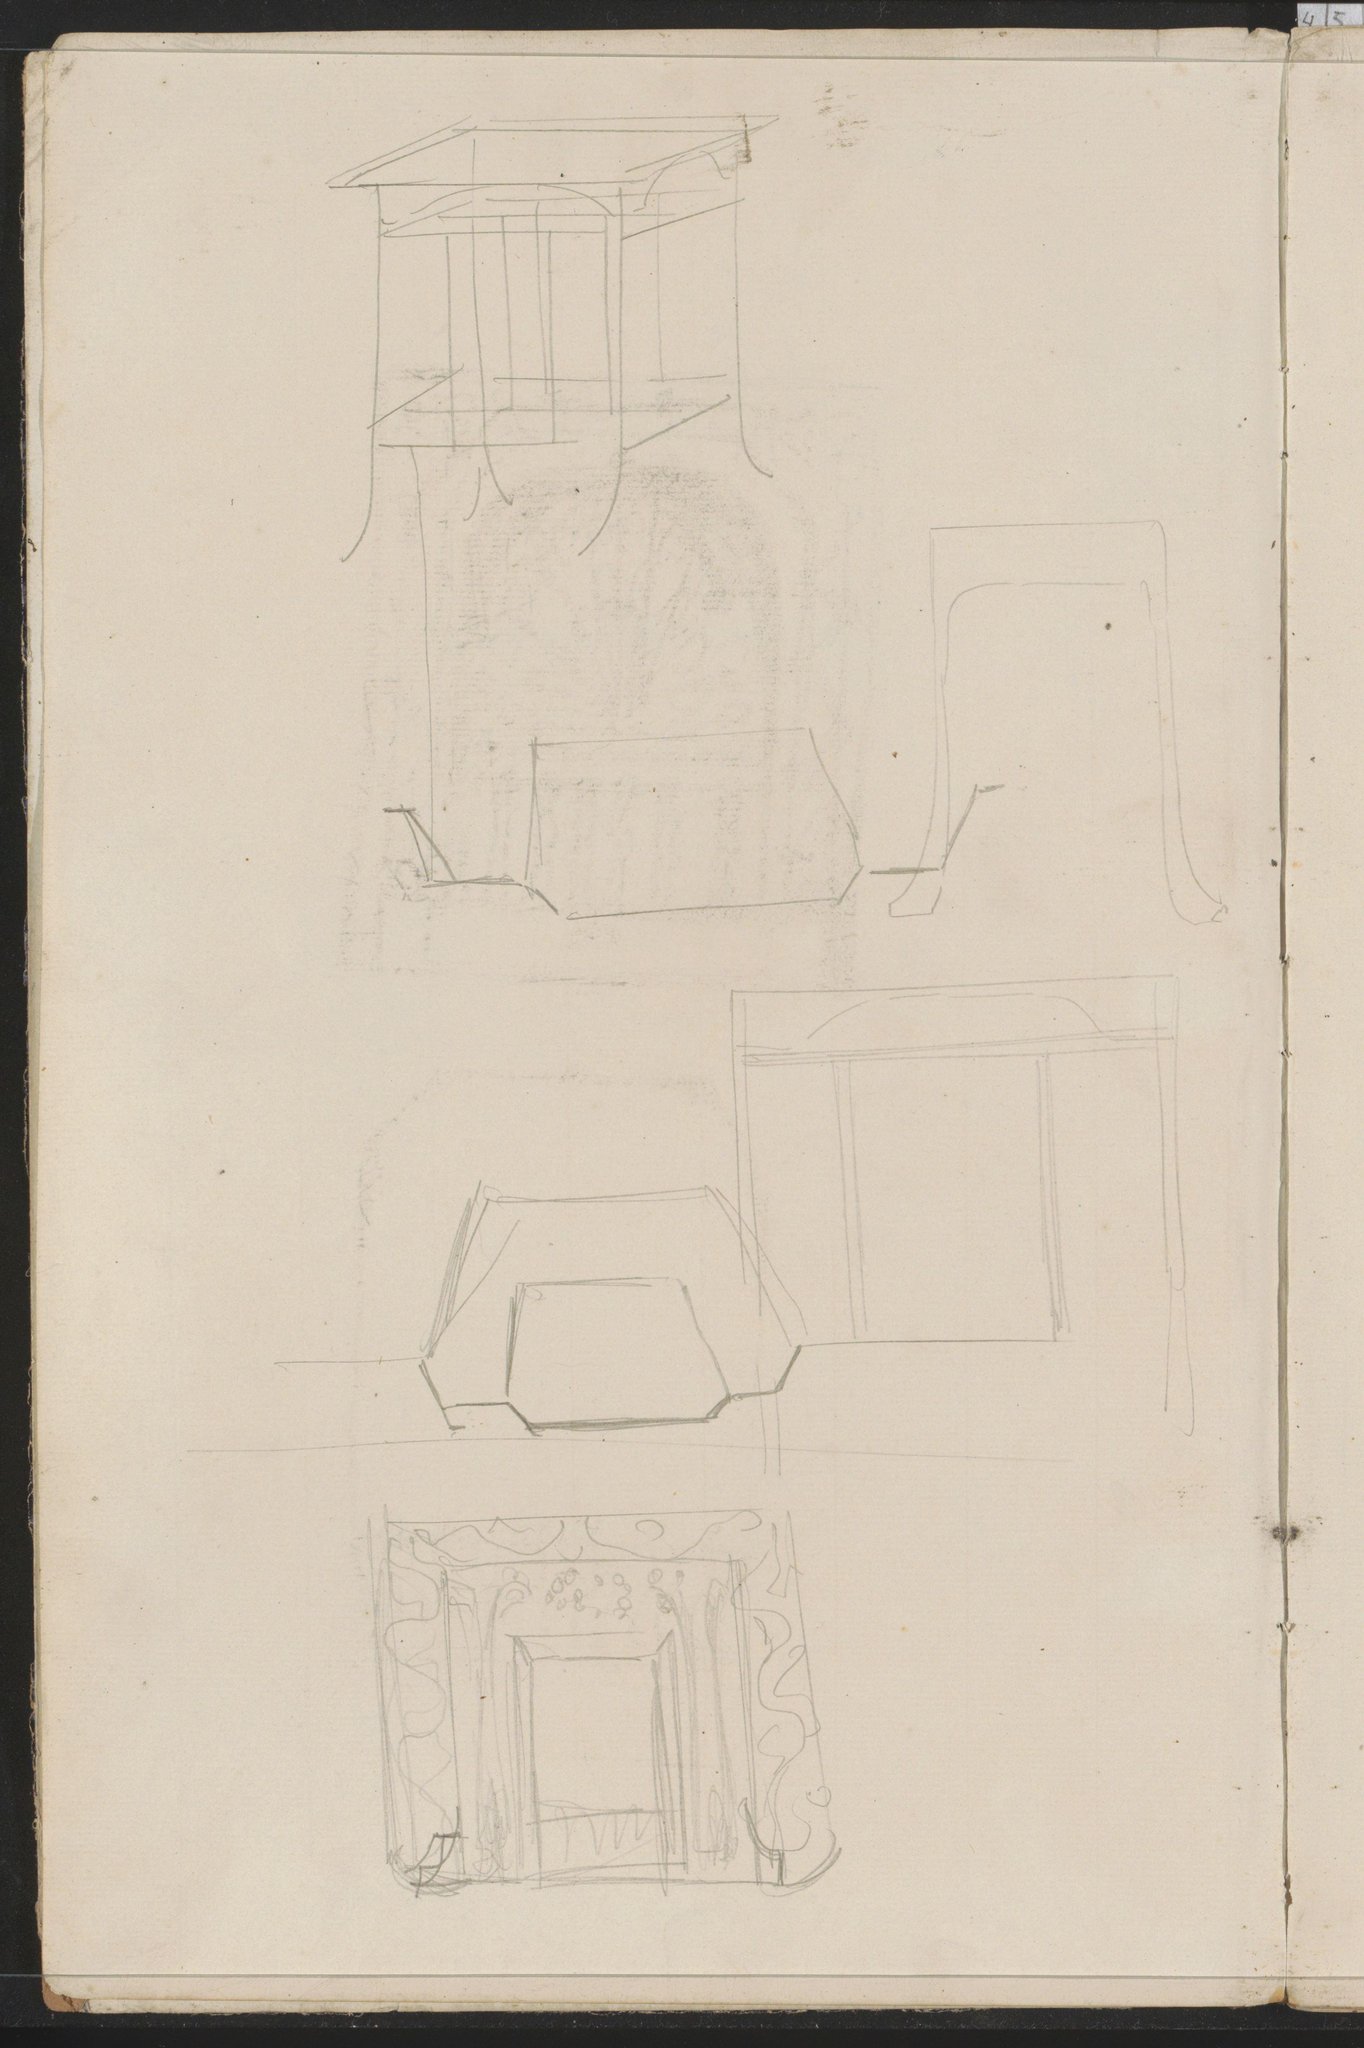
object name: sketchbook leaf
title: Ontwerpen voor bijzettafels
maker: carel adolph lion cachet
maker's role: draughtsman, print maker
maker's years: 1864-1945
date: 1897-1898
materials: paper, pencil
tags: table, chair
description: Blad 1 verso uit een schetsboek met 29 bladen.